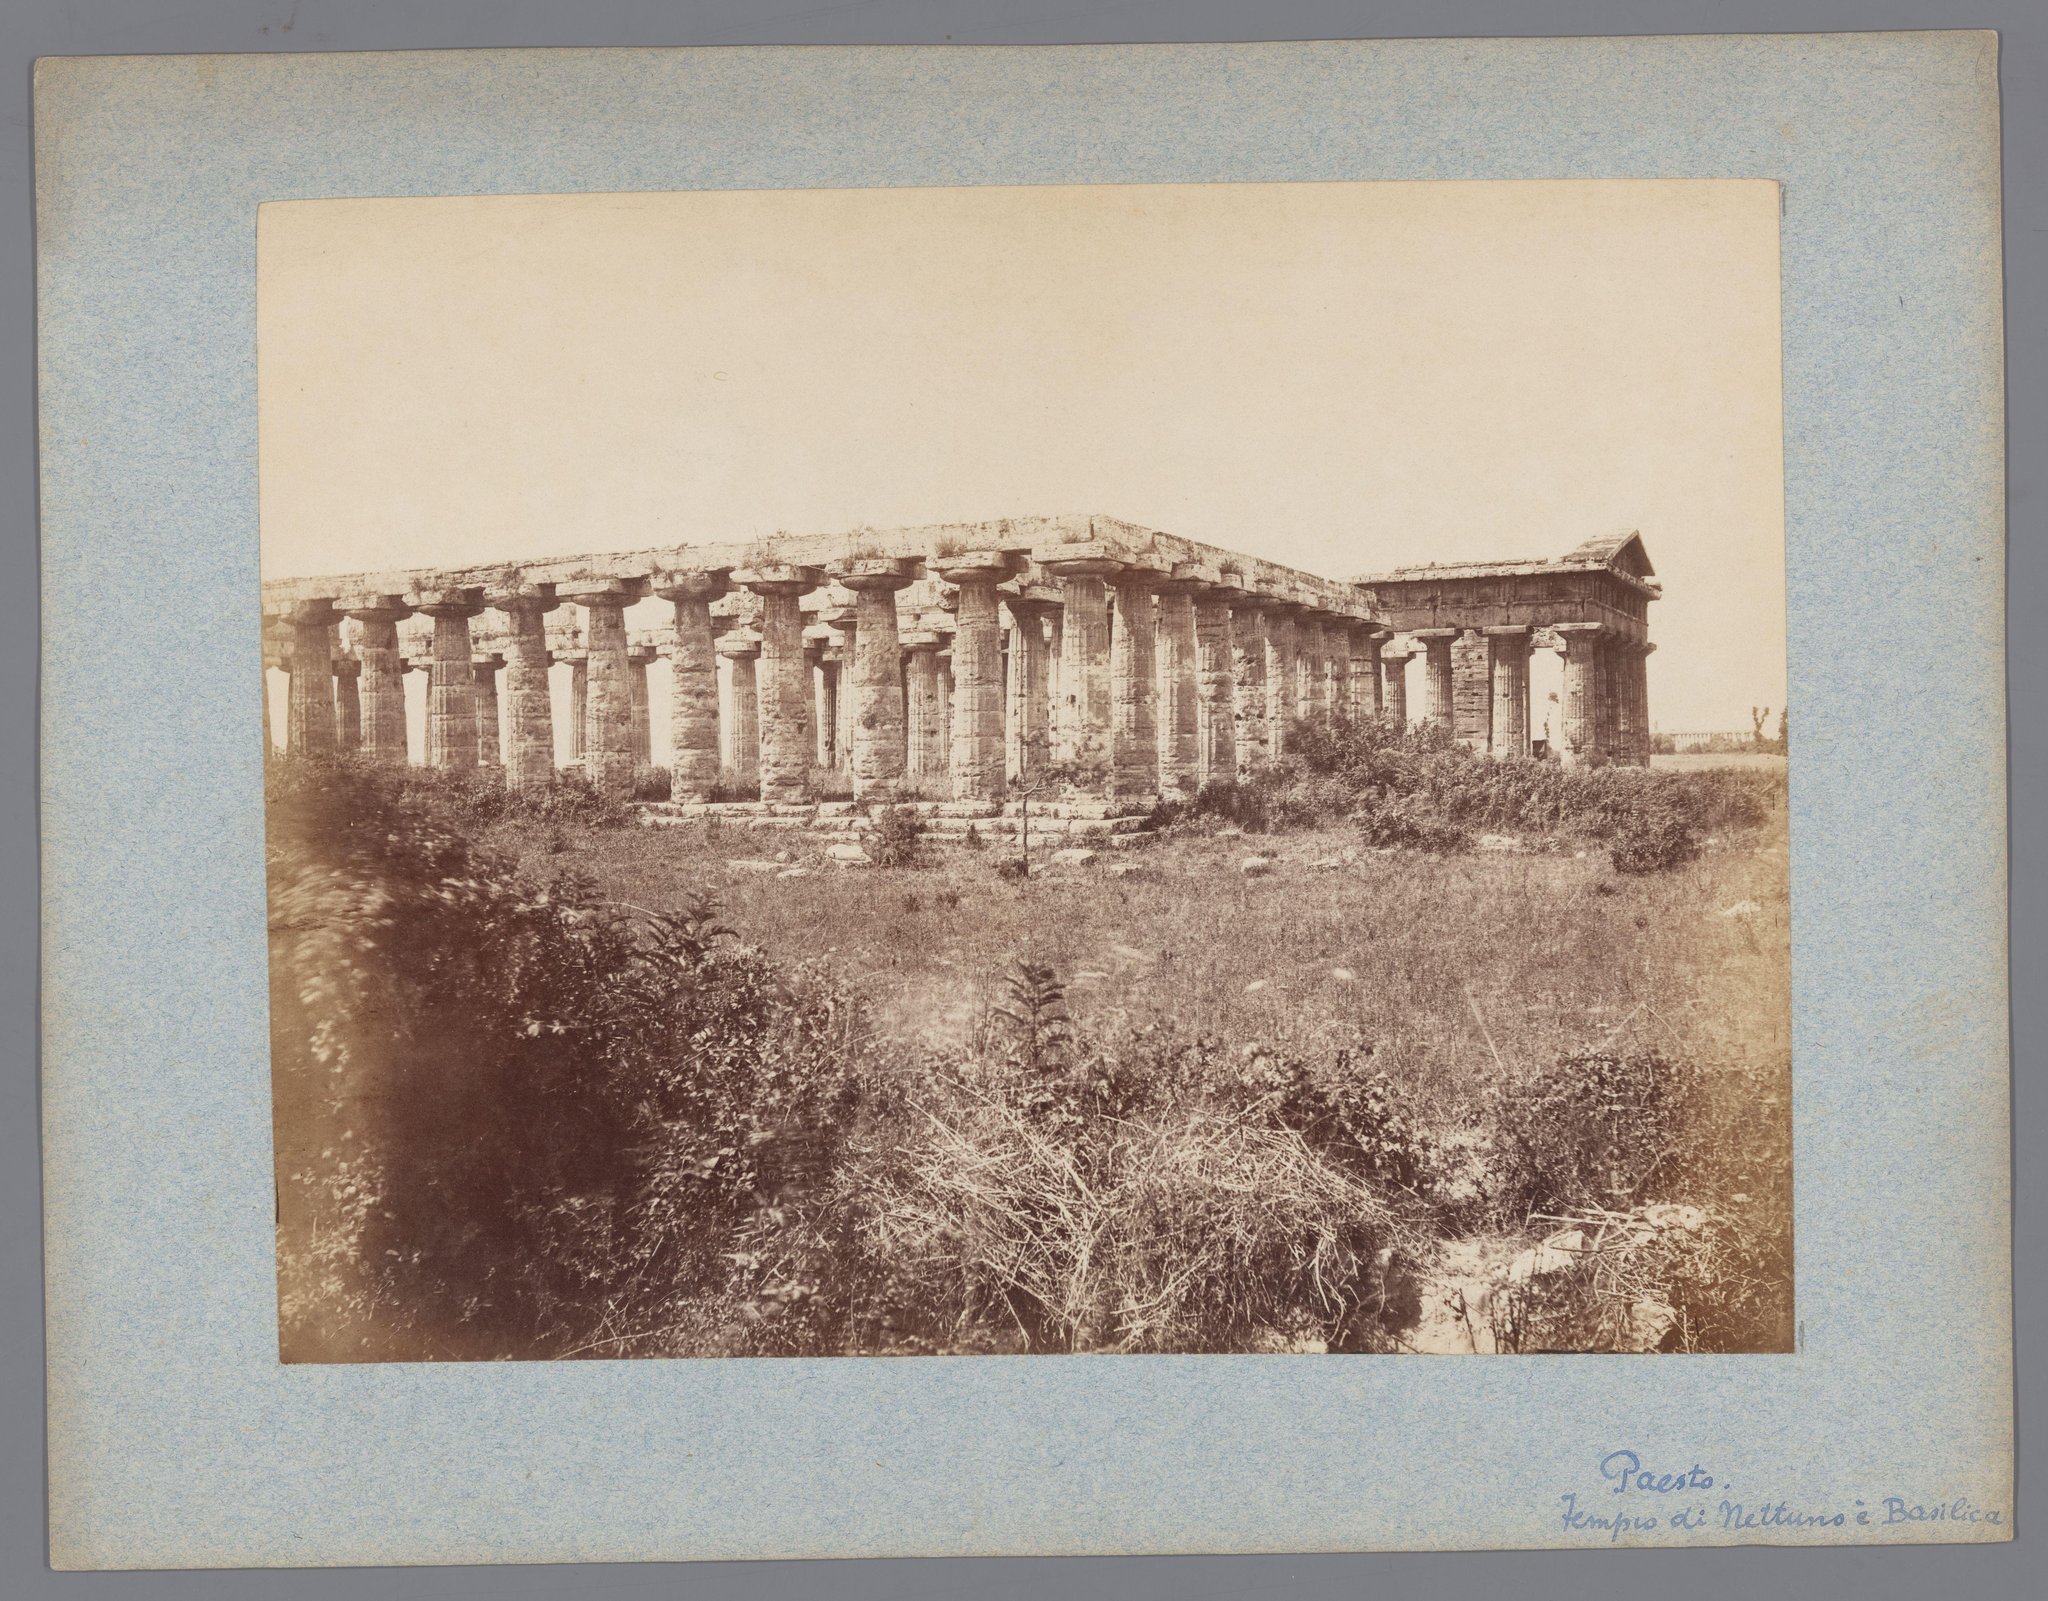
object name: photograph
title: Tempels van Juno te Paestum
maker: Anonymous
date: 1851-1900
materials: cardboard, paper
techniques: albumen print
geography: paestum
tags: church (exterior), places and objects of worship ~ non-christian religions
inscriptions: collector's mark: ‘VOSMAER’, number: ‘1179’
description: Men heeft lange tijd ten onrechte aangenomen dat de voorste tempel een Basilica was en dat de achterste tempel de Tempel van Neptunus is geweest.